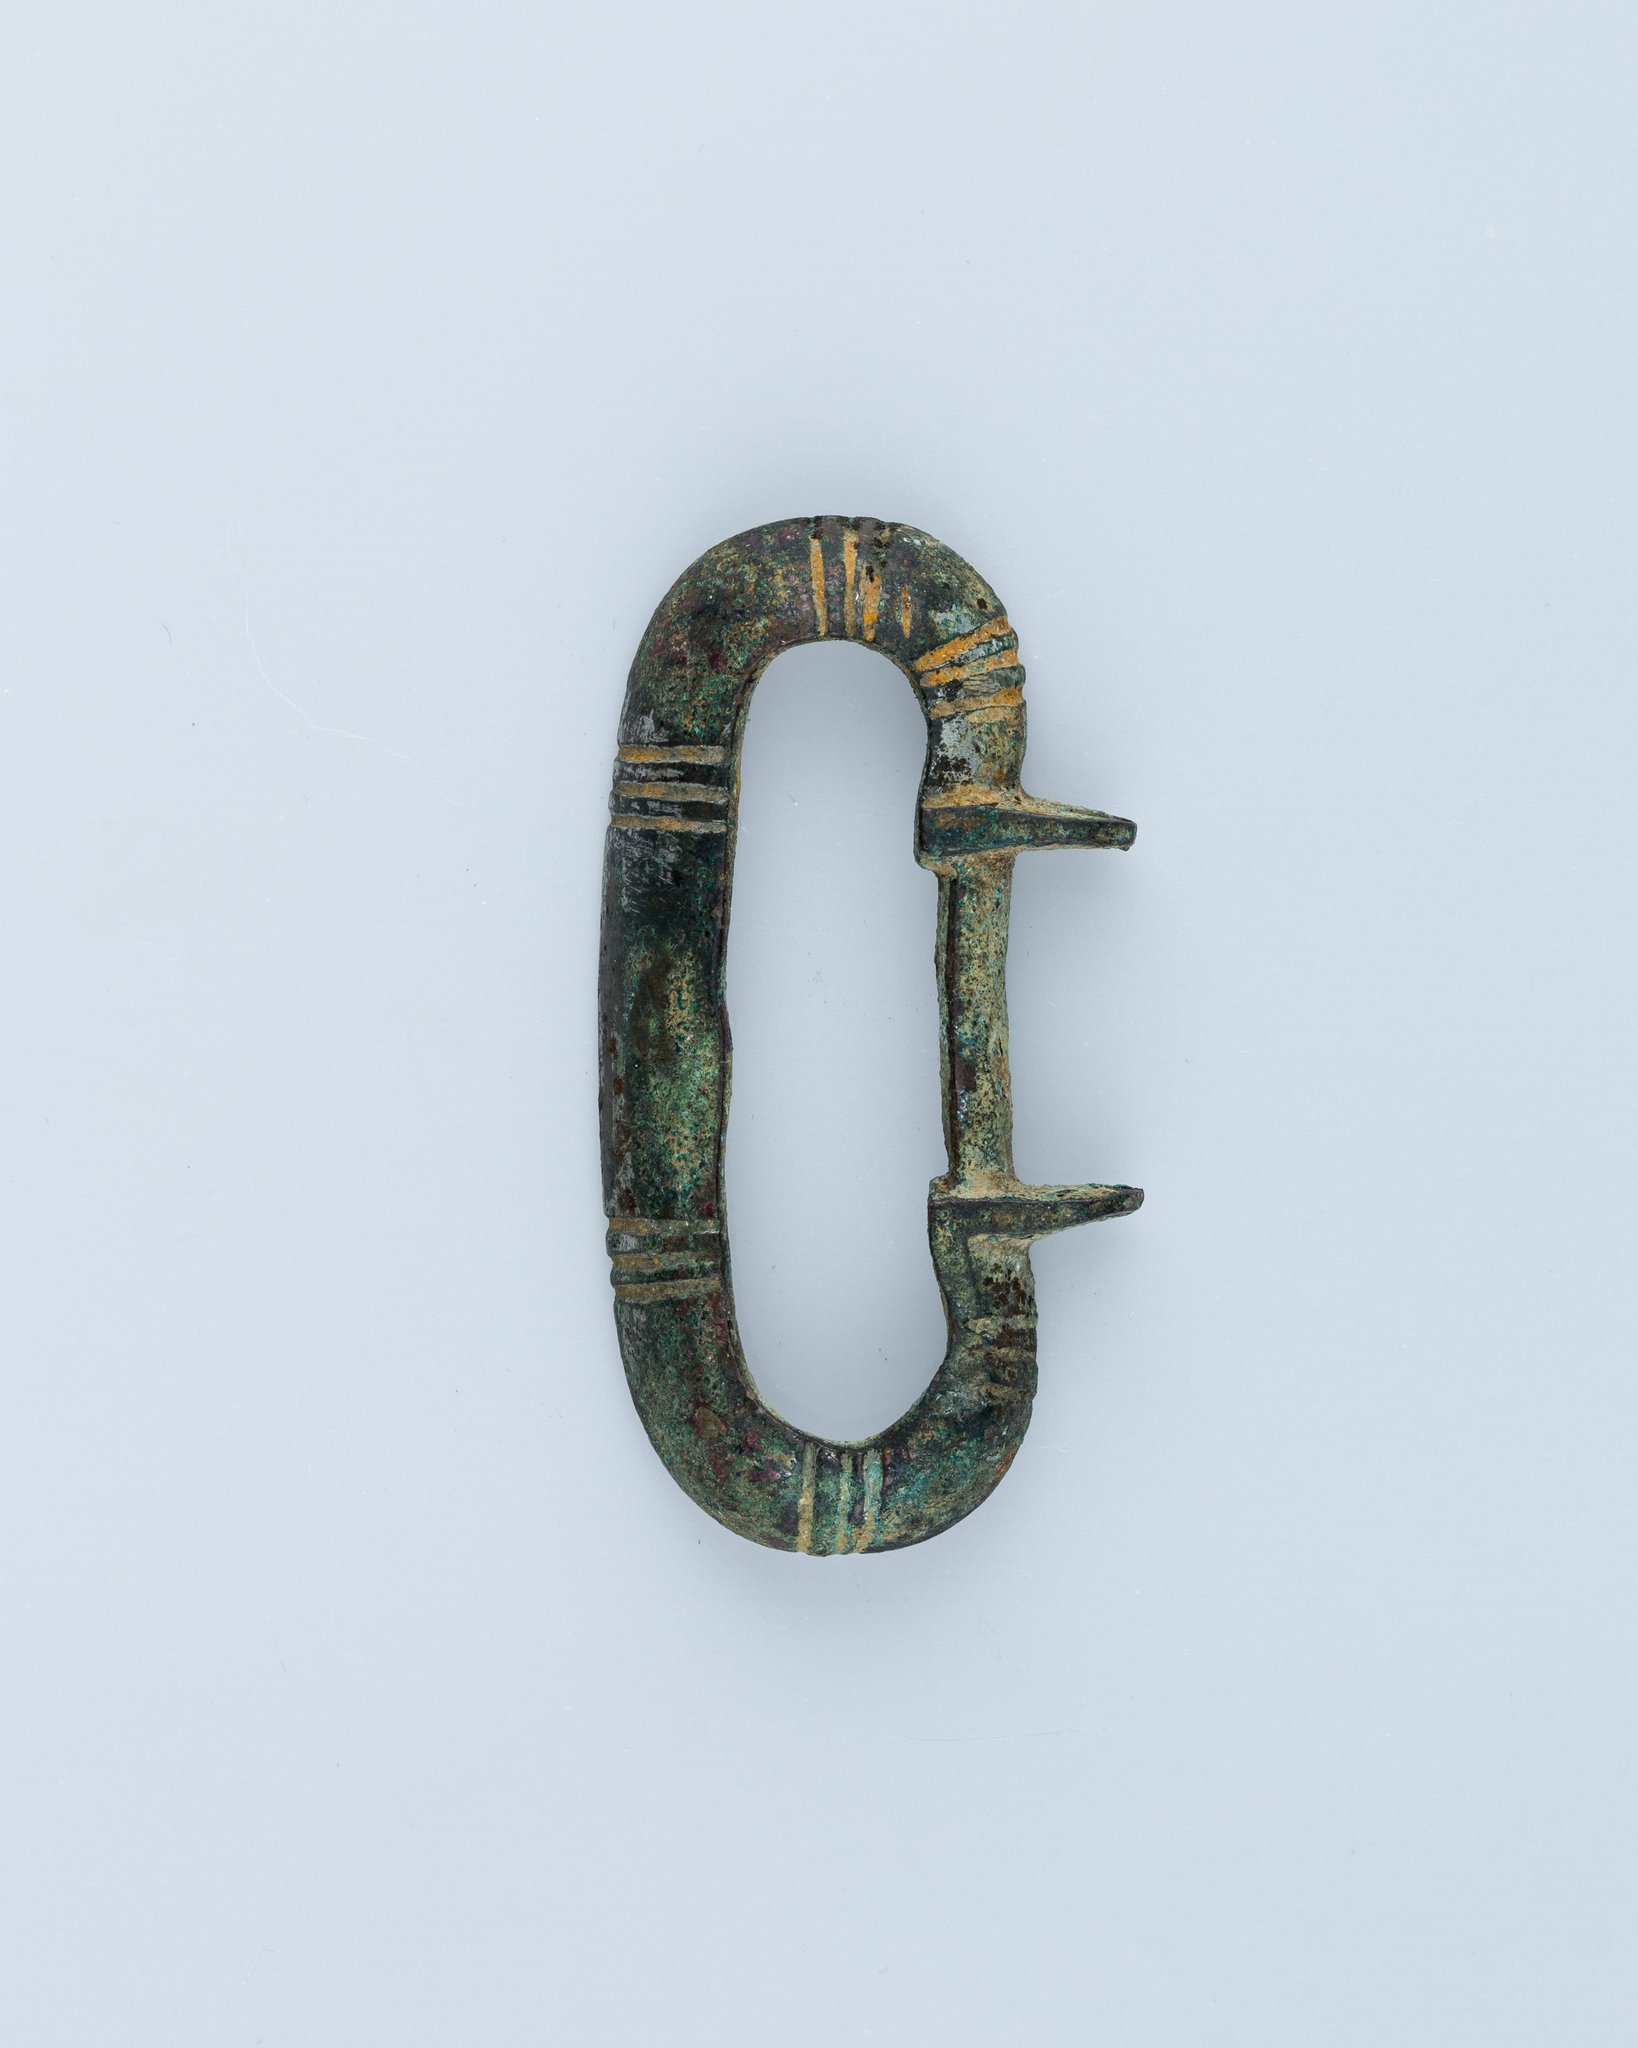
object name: buckle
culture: ibero-roman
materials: bronze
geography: spain or portugal